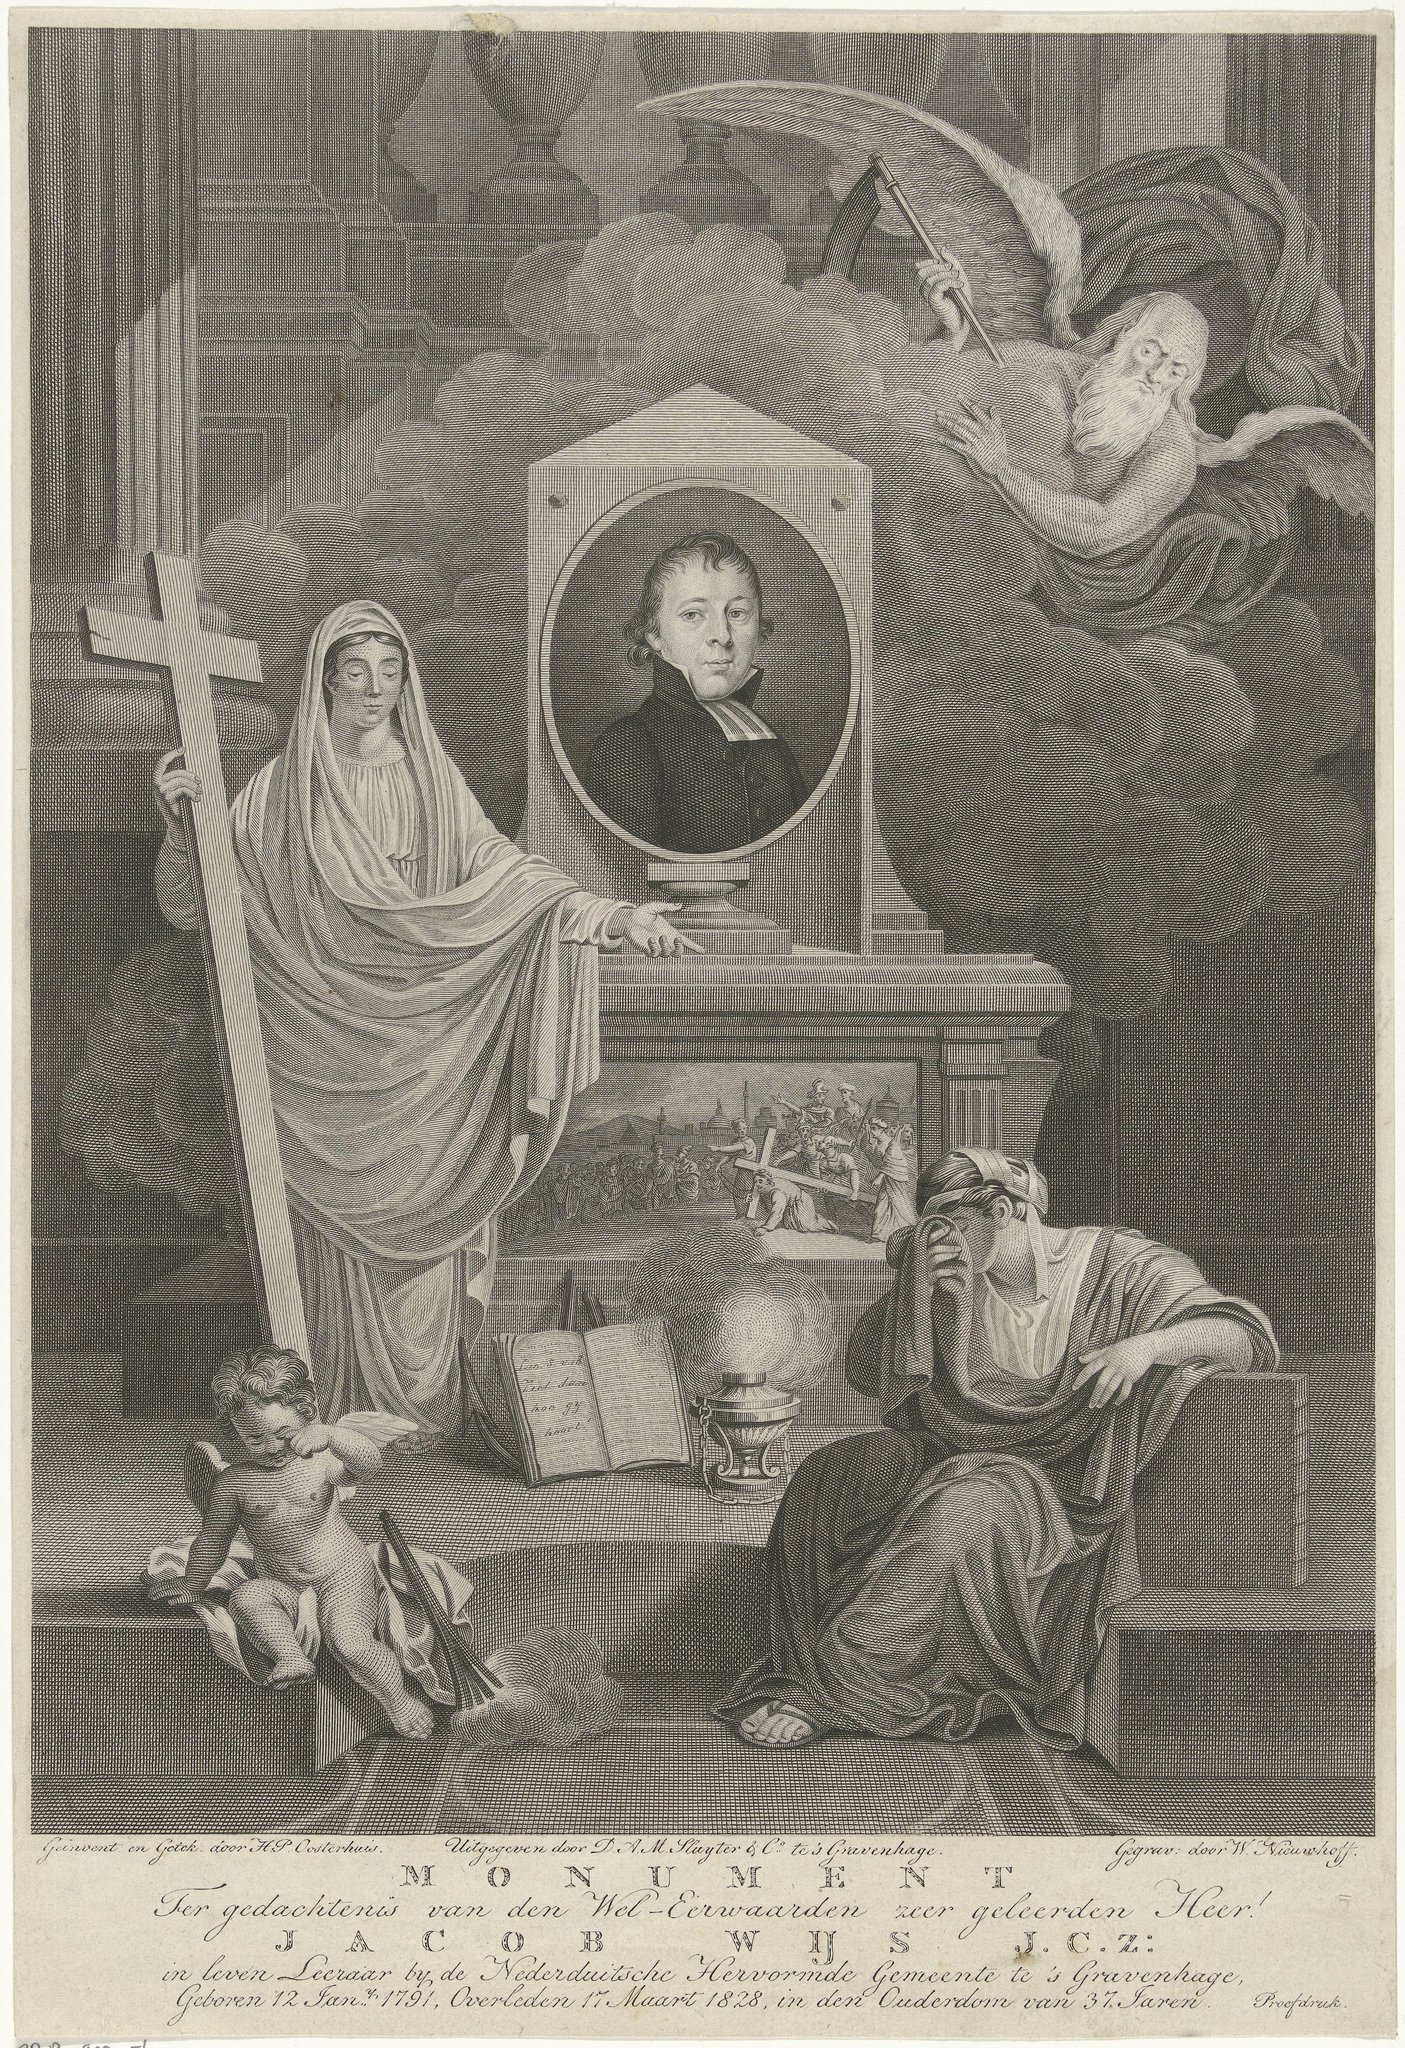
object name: print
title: Gedenkteken voor Jacob Wijs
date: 1828-1830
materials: paper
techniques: engraving, etching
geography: the hague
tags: torch - bb - torch held upside down (+ extinguishing; extinguished light, lamp, candle), faith, 'fides'; 'fede', 'fede catholica', 'fede christiana', 'fede christiana catholica' (ripa) ~ one of the three theological virtues, monument, statue, father time, man with wings and scythe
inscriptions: collector's mark: Lugt 2228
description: Een gedenkteken voor Jacob Wijs, predikant te Den Haag. Het monument wordt bekroond met zijn portret. Op het onderste gedeelte van het monument is de kruisdraging van Christus afgebeeld. Naast het monument staat het Geloof met een kruis in haar hand. Op de rand van het podium zitten een treurende vrouwfiguur en de treurende Amor met een omgekeerde toorts. In de wolk achter het monument verschijnt Vadertje Tijd met zijn zeis. Onderaan in de marge een vijfregelige tekst in het Nederlands.